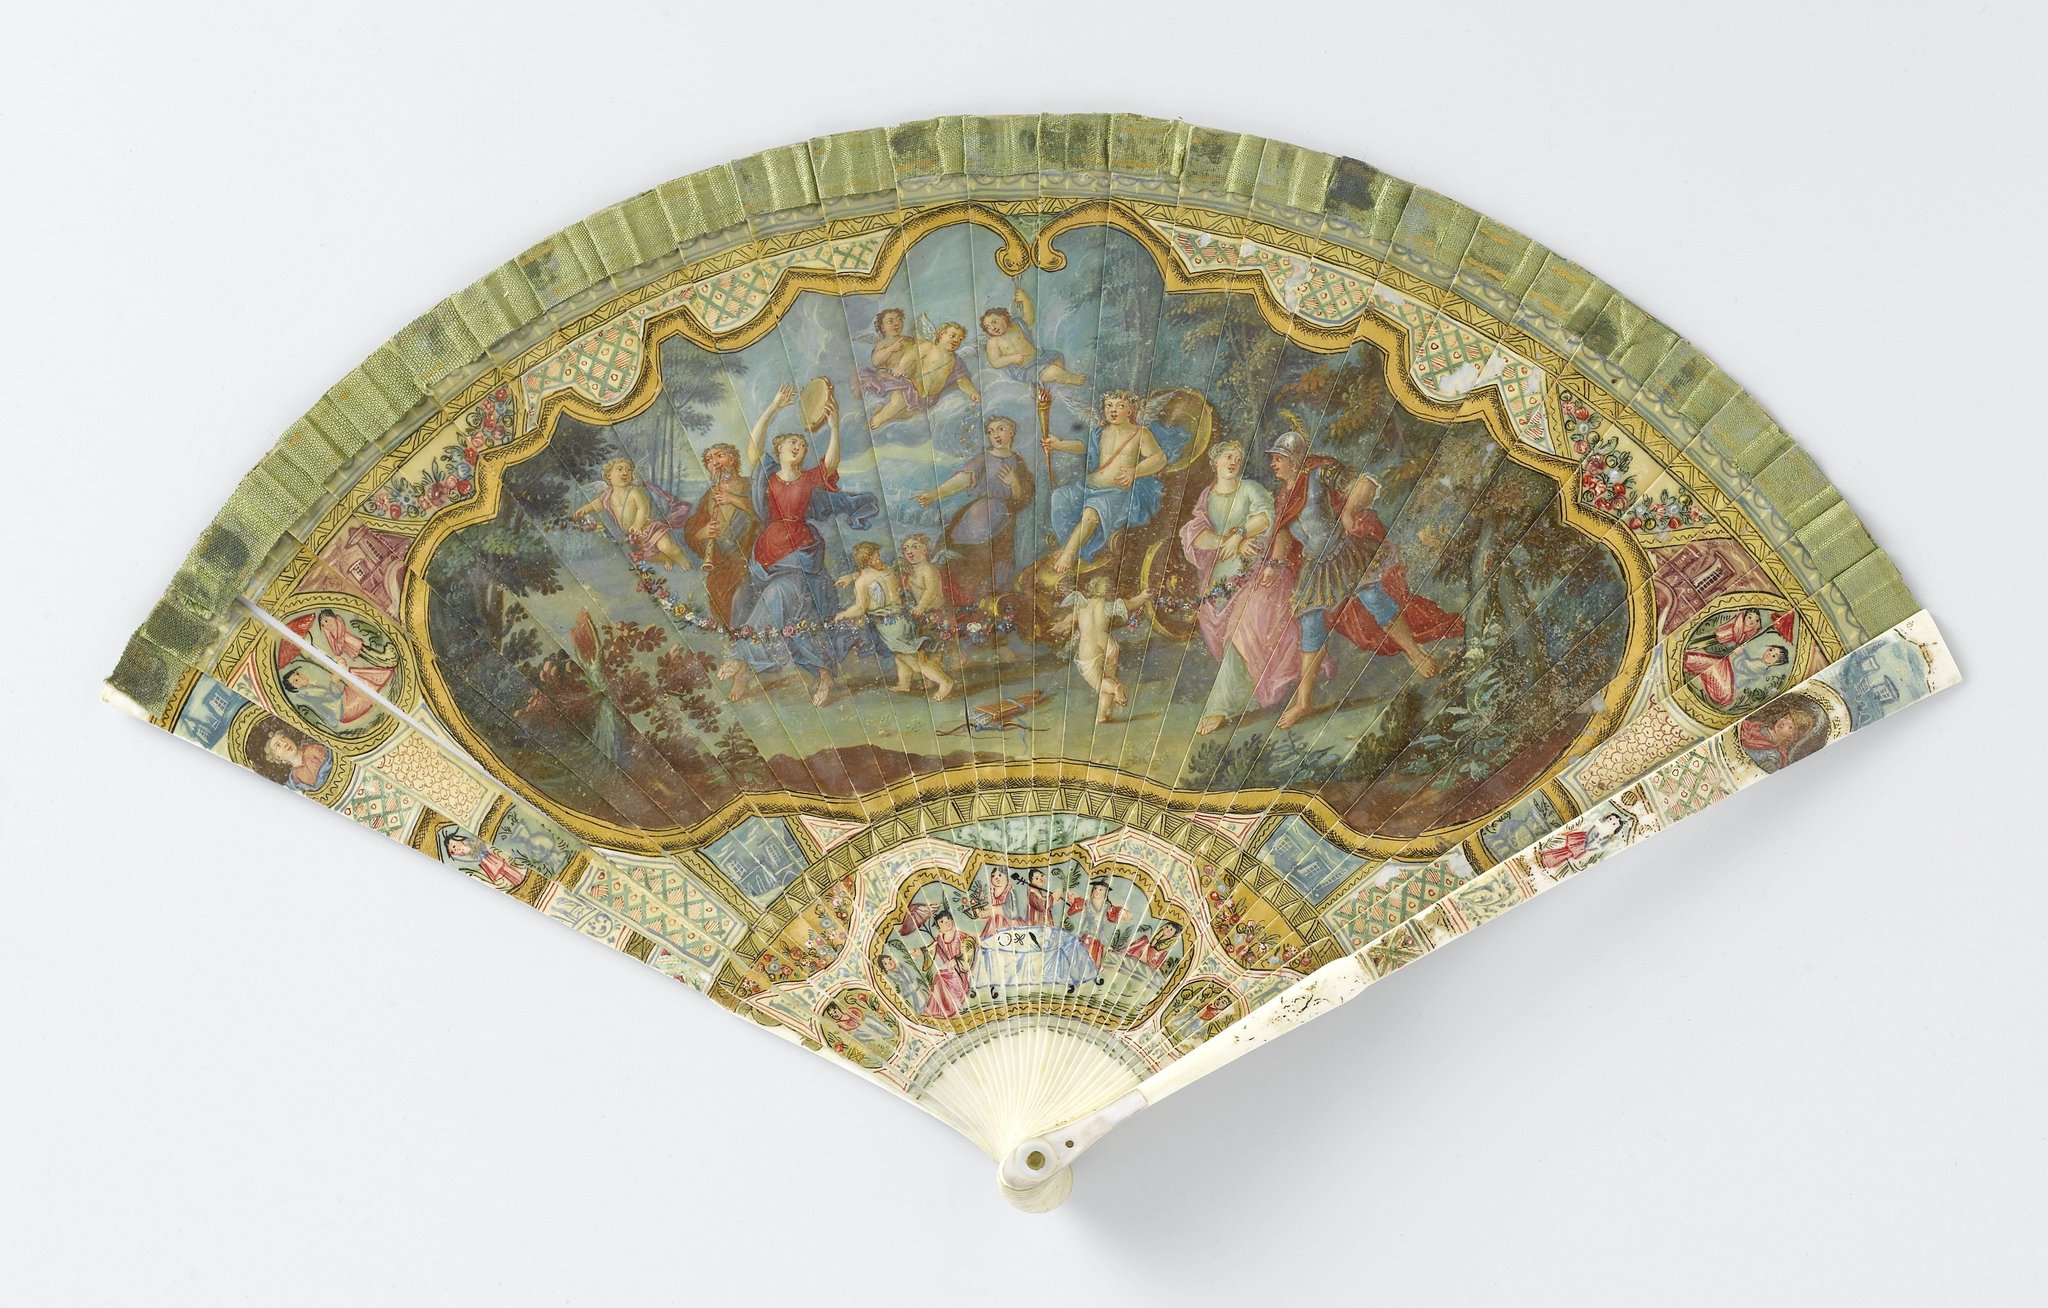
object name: brisé fan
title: Briséwaaier van ivoor, geheel beschilderd met tempera waarover een lakachtige vernis, met een centrale cartouche waarin 'de Triomf van de Liefde' aan de voorkant en een arcadisch zeegezicht aan de achterkant, omgeven door chinoiserieëen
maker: Anonymous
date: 1700-1750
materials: lacquer, metal, mother of pearl, silk, paint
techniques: cutting, lacquer, painted, weave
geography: france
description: Briséwaaier van ivoor, geheel beschilderd met tempera waarover een lakachtige vernis, met een centrale cartouche waarin 'de Triomf van de Liefde' aan de voorkant en een arcadisch zeegezicht aan de achterkant. Voorkant: hoewel de waiaer uit een geheel bestaat, wordt in de geschilderde decoratie getracht de illusie te wekken dat de waaier toch uit een blad en een montuur bestaat. De losse benen worden aan de bovenkant door middel van een lint met elkaar verbonden. De Triomf van Eros; Eros zit op een zegekar, voorafgegaan door musicerende figuren en eroten. Rechts van deze groep zijn twee geliefden, hoogstwaarschijnlijk Mars en Venus, afgebeeld. De allegorische voorstelling grijpt terug op de 'Trionfi' van Petrarca uit 1352, waarin deze als een van de eersten abstracte ideeën personifiëerde en hen in triomf op een zegekar plaatste. Rondom de cartouche rasterwerk en chinoiserieën. Achterkant: een arcadisch zeegezicht. Rondom de cartouche rasterwerk en chinoiserieën. Op de buitenbenen zijn boven aan beide zijden antieke portretjes geschilderd. Na de oprichting van Vereenigde Oostindische Compagnie in 1602 kwam een beperkte aanvoer van gelakte voorwerpen uit China en Japan naar Europa op gang. Rond het midden van de 17de eeuw was de vraag naar dit schaarse en daarom bijzonder begerenswaardige lakwerk zo gestegen, dat men in Engeland en de Republiek begon het oosterse voorbeeld te imiteren. Nog voordat de 'Vernis Martin' in 1730 gepatenteerd was, werd al getracht deze te imiteren.